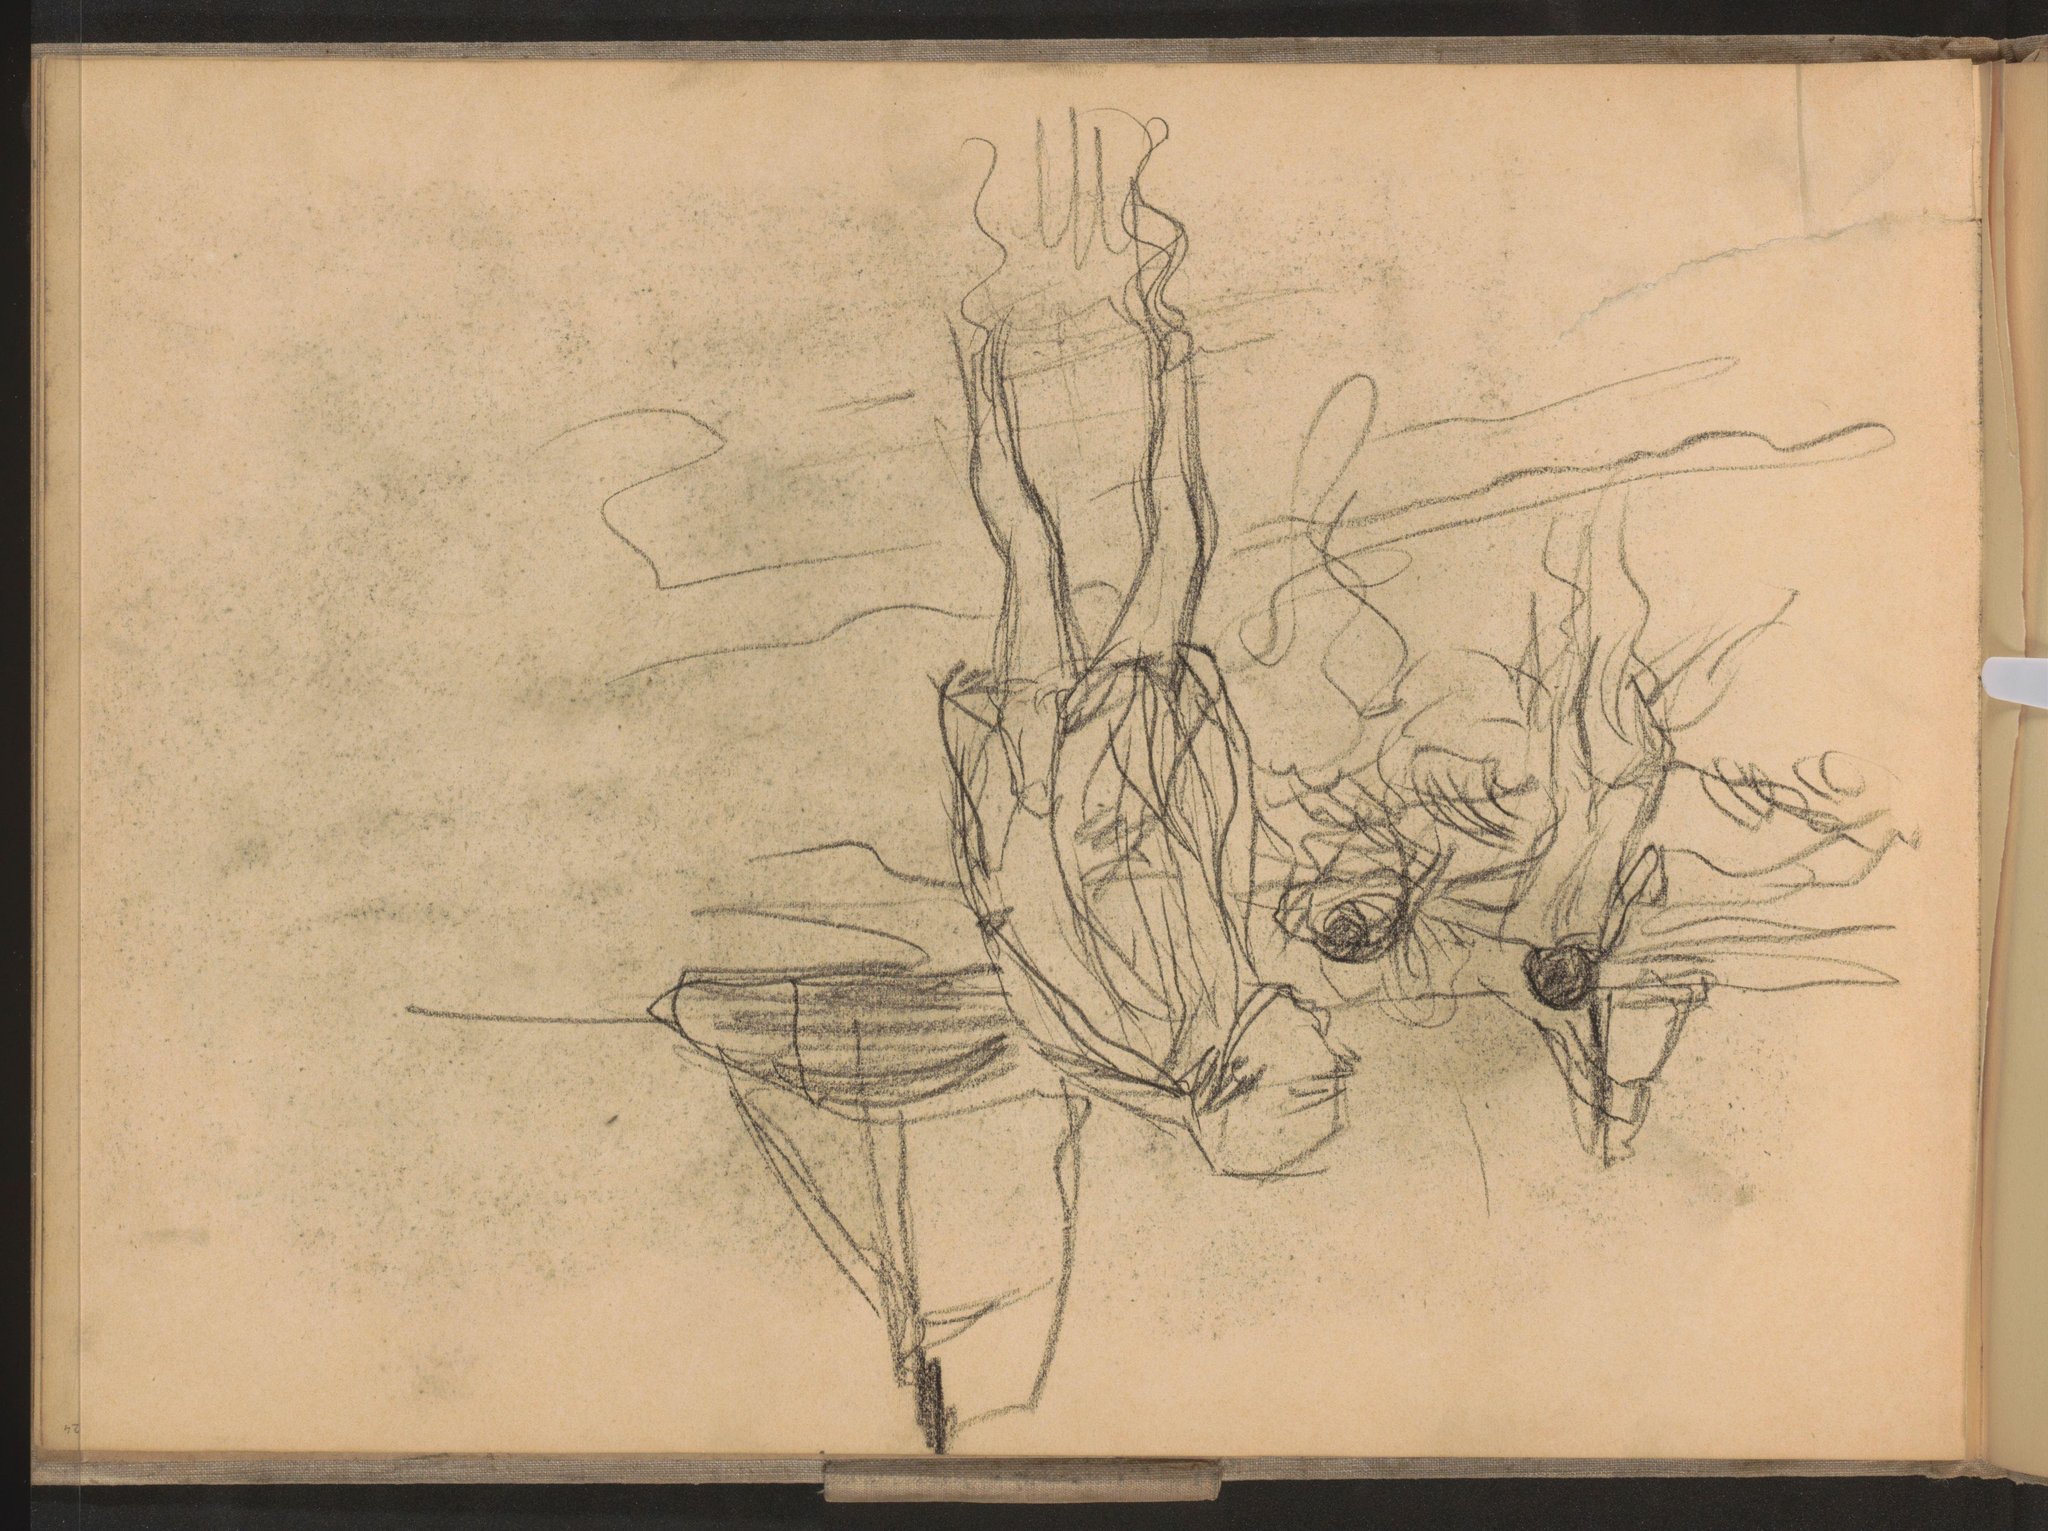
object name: sketchbook leaf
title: Spelende kinderen aan de vloedlijn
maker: marius bauer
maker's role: draughtsman, print maker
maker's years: 1867-1932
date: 1887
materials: chalk, paper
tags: beach (as place of recreation), sailing-ship, sailing-boat, child, sea (seascape), wading, paddling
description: Op de achtergrond zijn twee zeilschepen op zee te zien. Pagina 24 uit een schetsboek met 19 bladen.